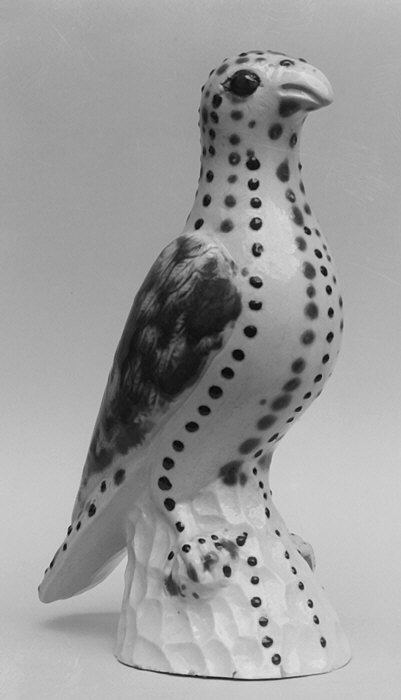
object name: figure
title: Parrot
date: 1750-1760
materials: stoneware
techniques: salt glaze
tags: parrots